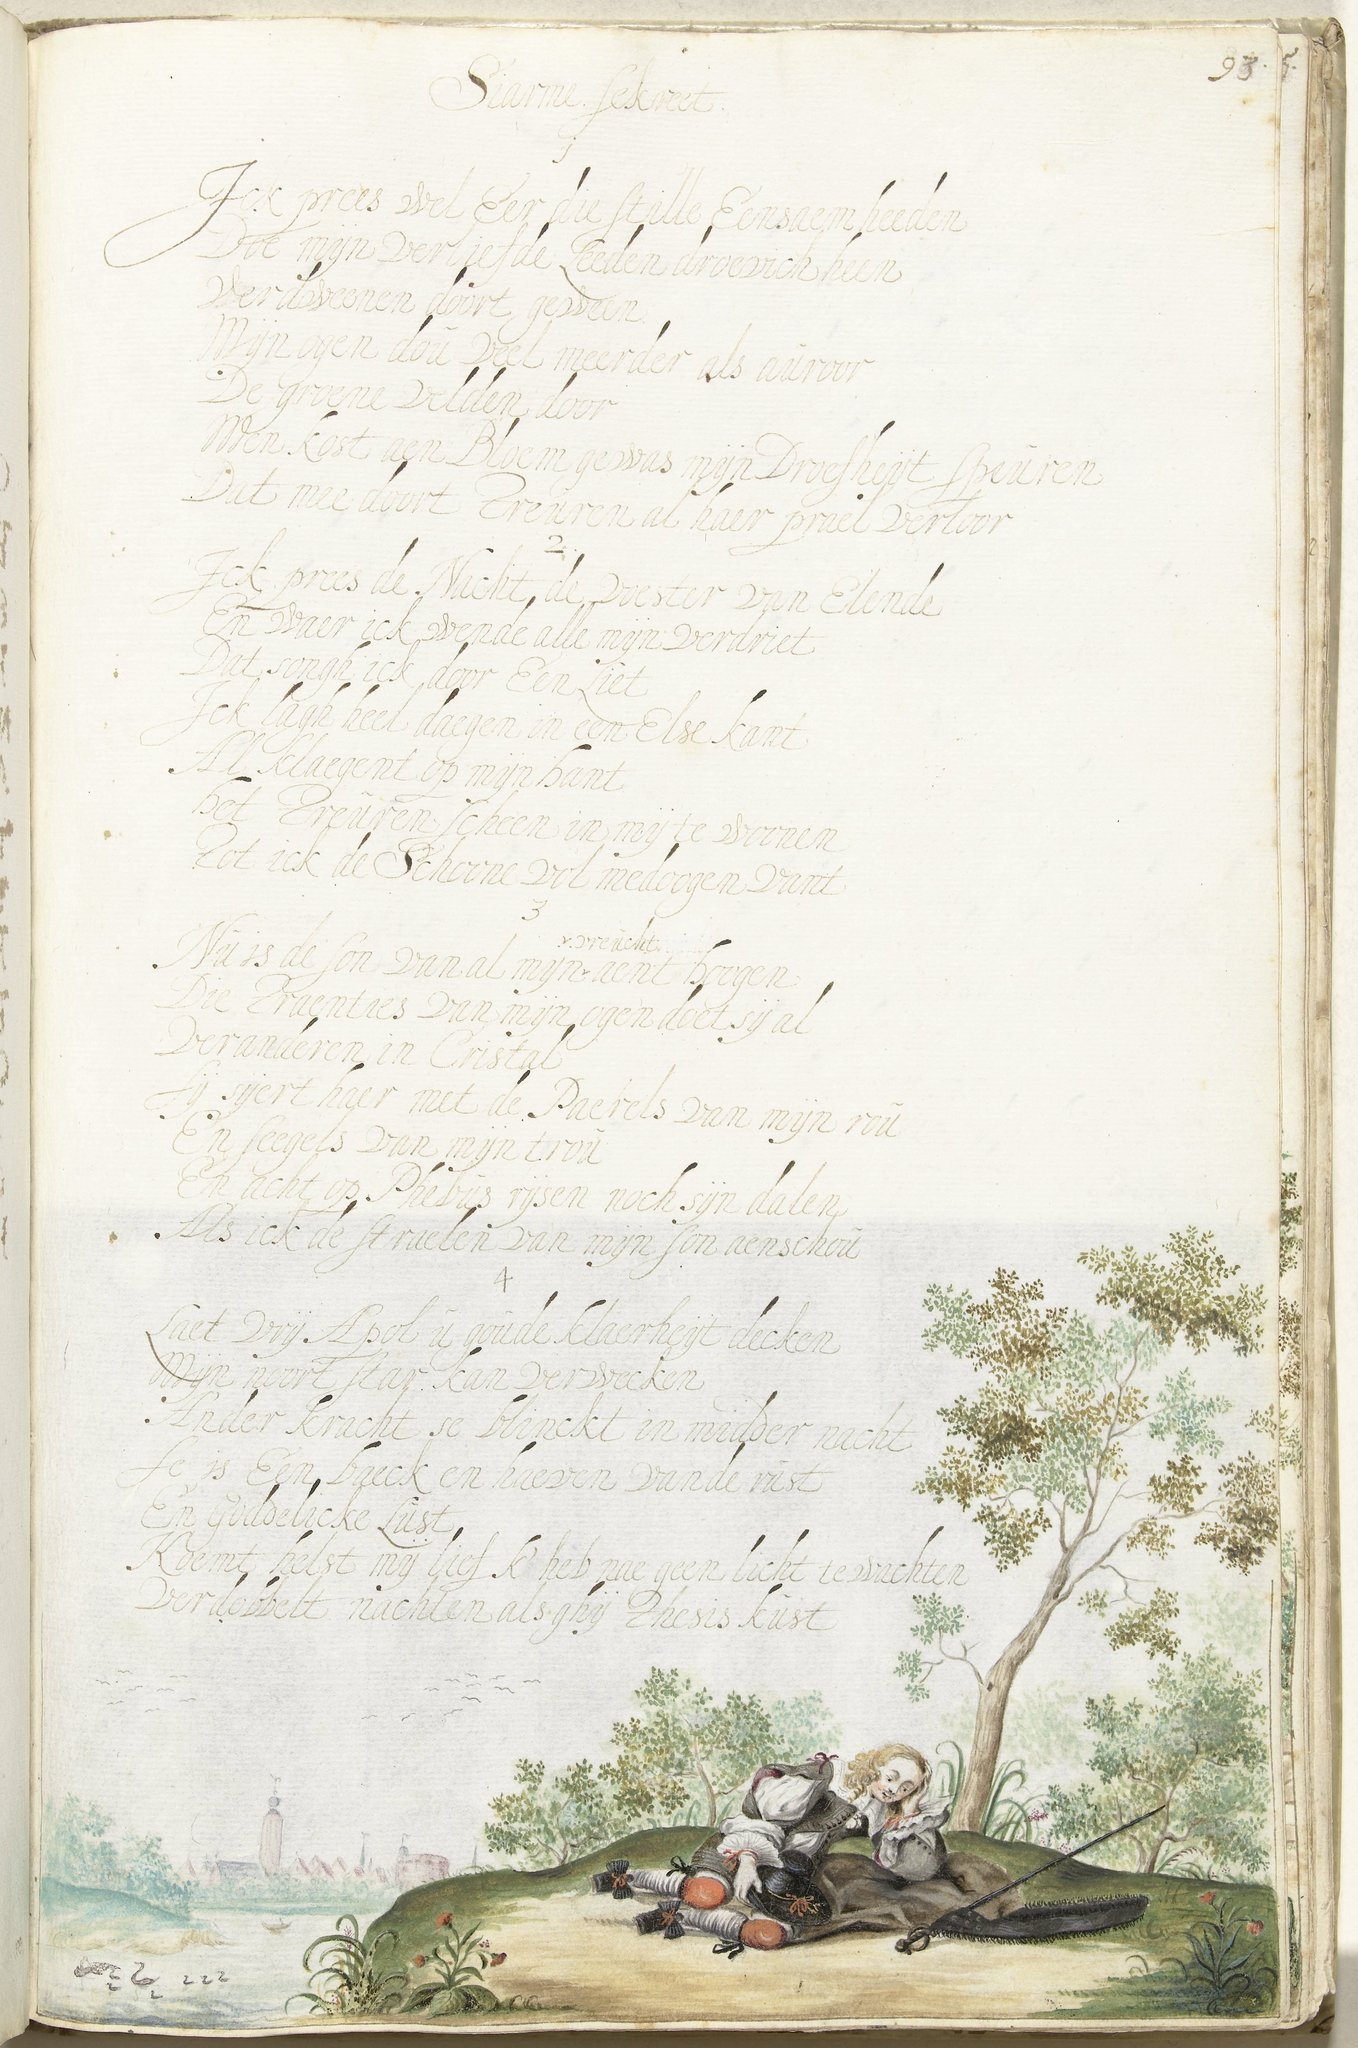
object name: drawing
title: Heer liggend op de grond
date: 1659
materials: ink, paper, watercolor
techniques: brush, calligraphy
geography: zwolle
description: Heer liggend op de grond met zijn hoofd op zijn hand naast liefdesklacht op de melodie van Siarme Sekreet.